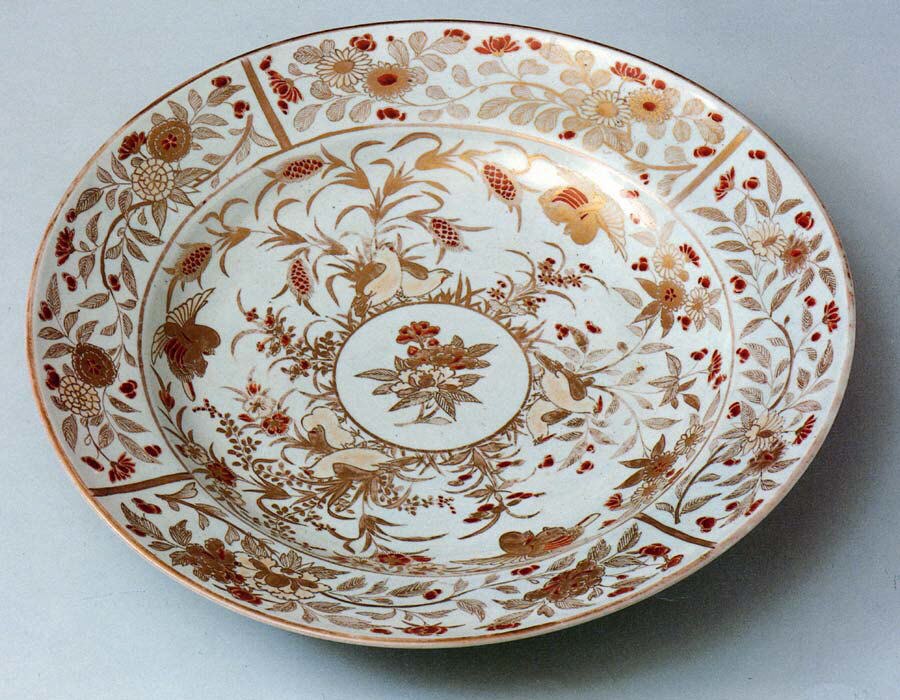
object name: plate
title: Plate with Decoration of Birds in Millet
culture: japanese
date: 1700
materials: enamel, gold, porcelain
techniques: overglaze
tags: birds,flowers,leaves